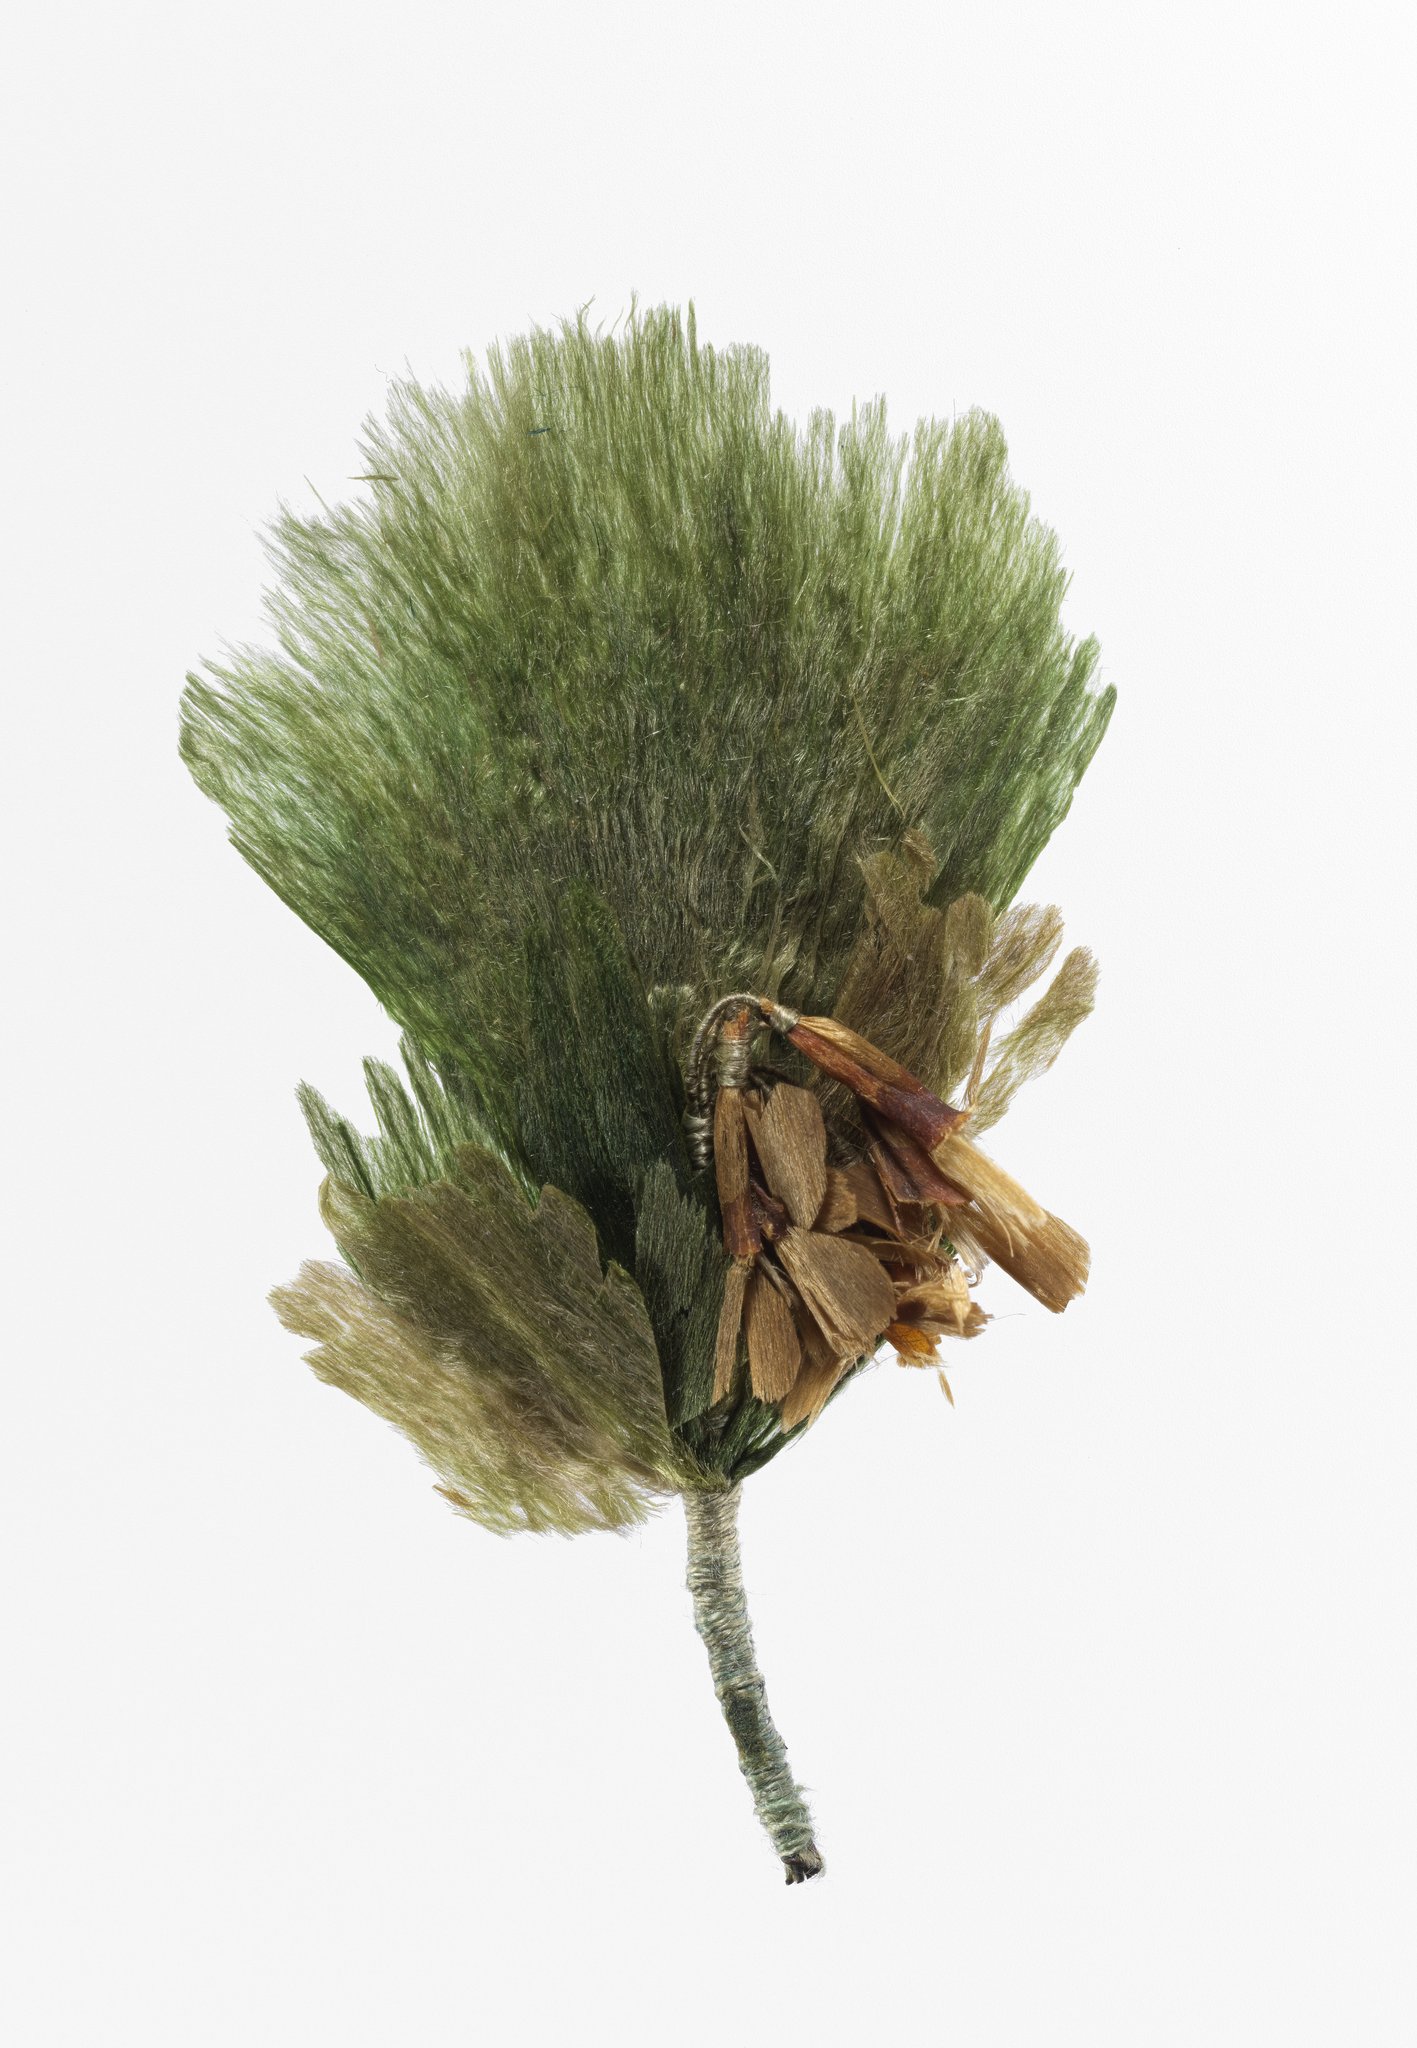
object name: boutonnière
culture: british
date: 1625-1649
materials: silk